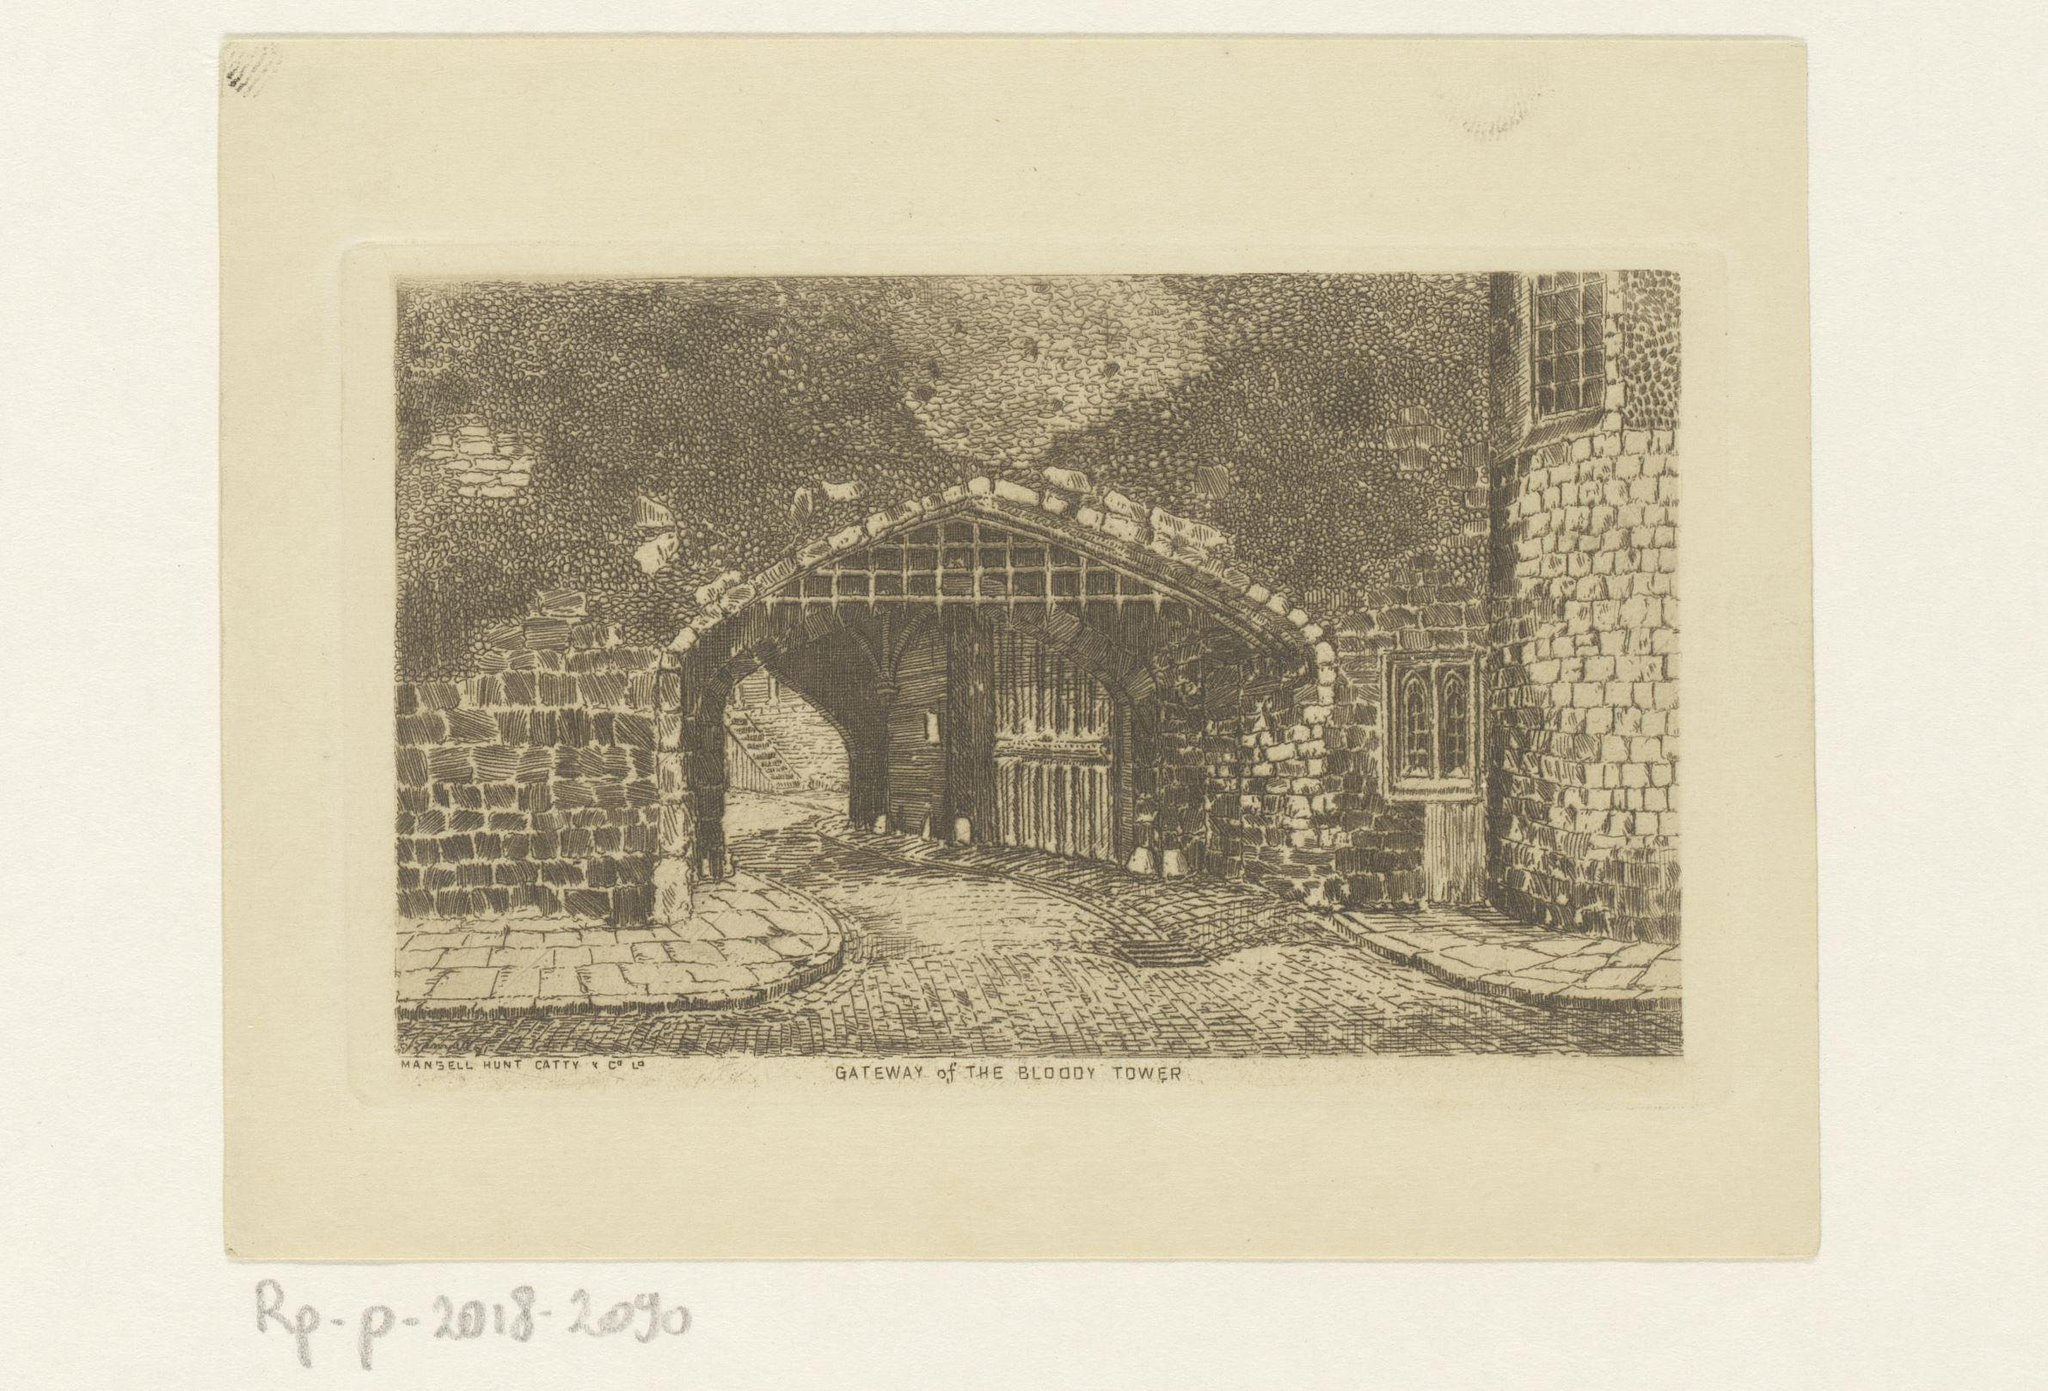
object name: print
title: Gateway of the Bloody Tower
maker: Anonymous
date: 1850-1949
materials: paper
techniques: etching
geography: london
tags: fortress, gate, entrance, tower (of house or building)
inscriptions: collector's mark: Lugt 2228